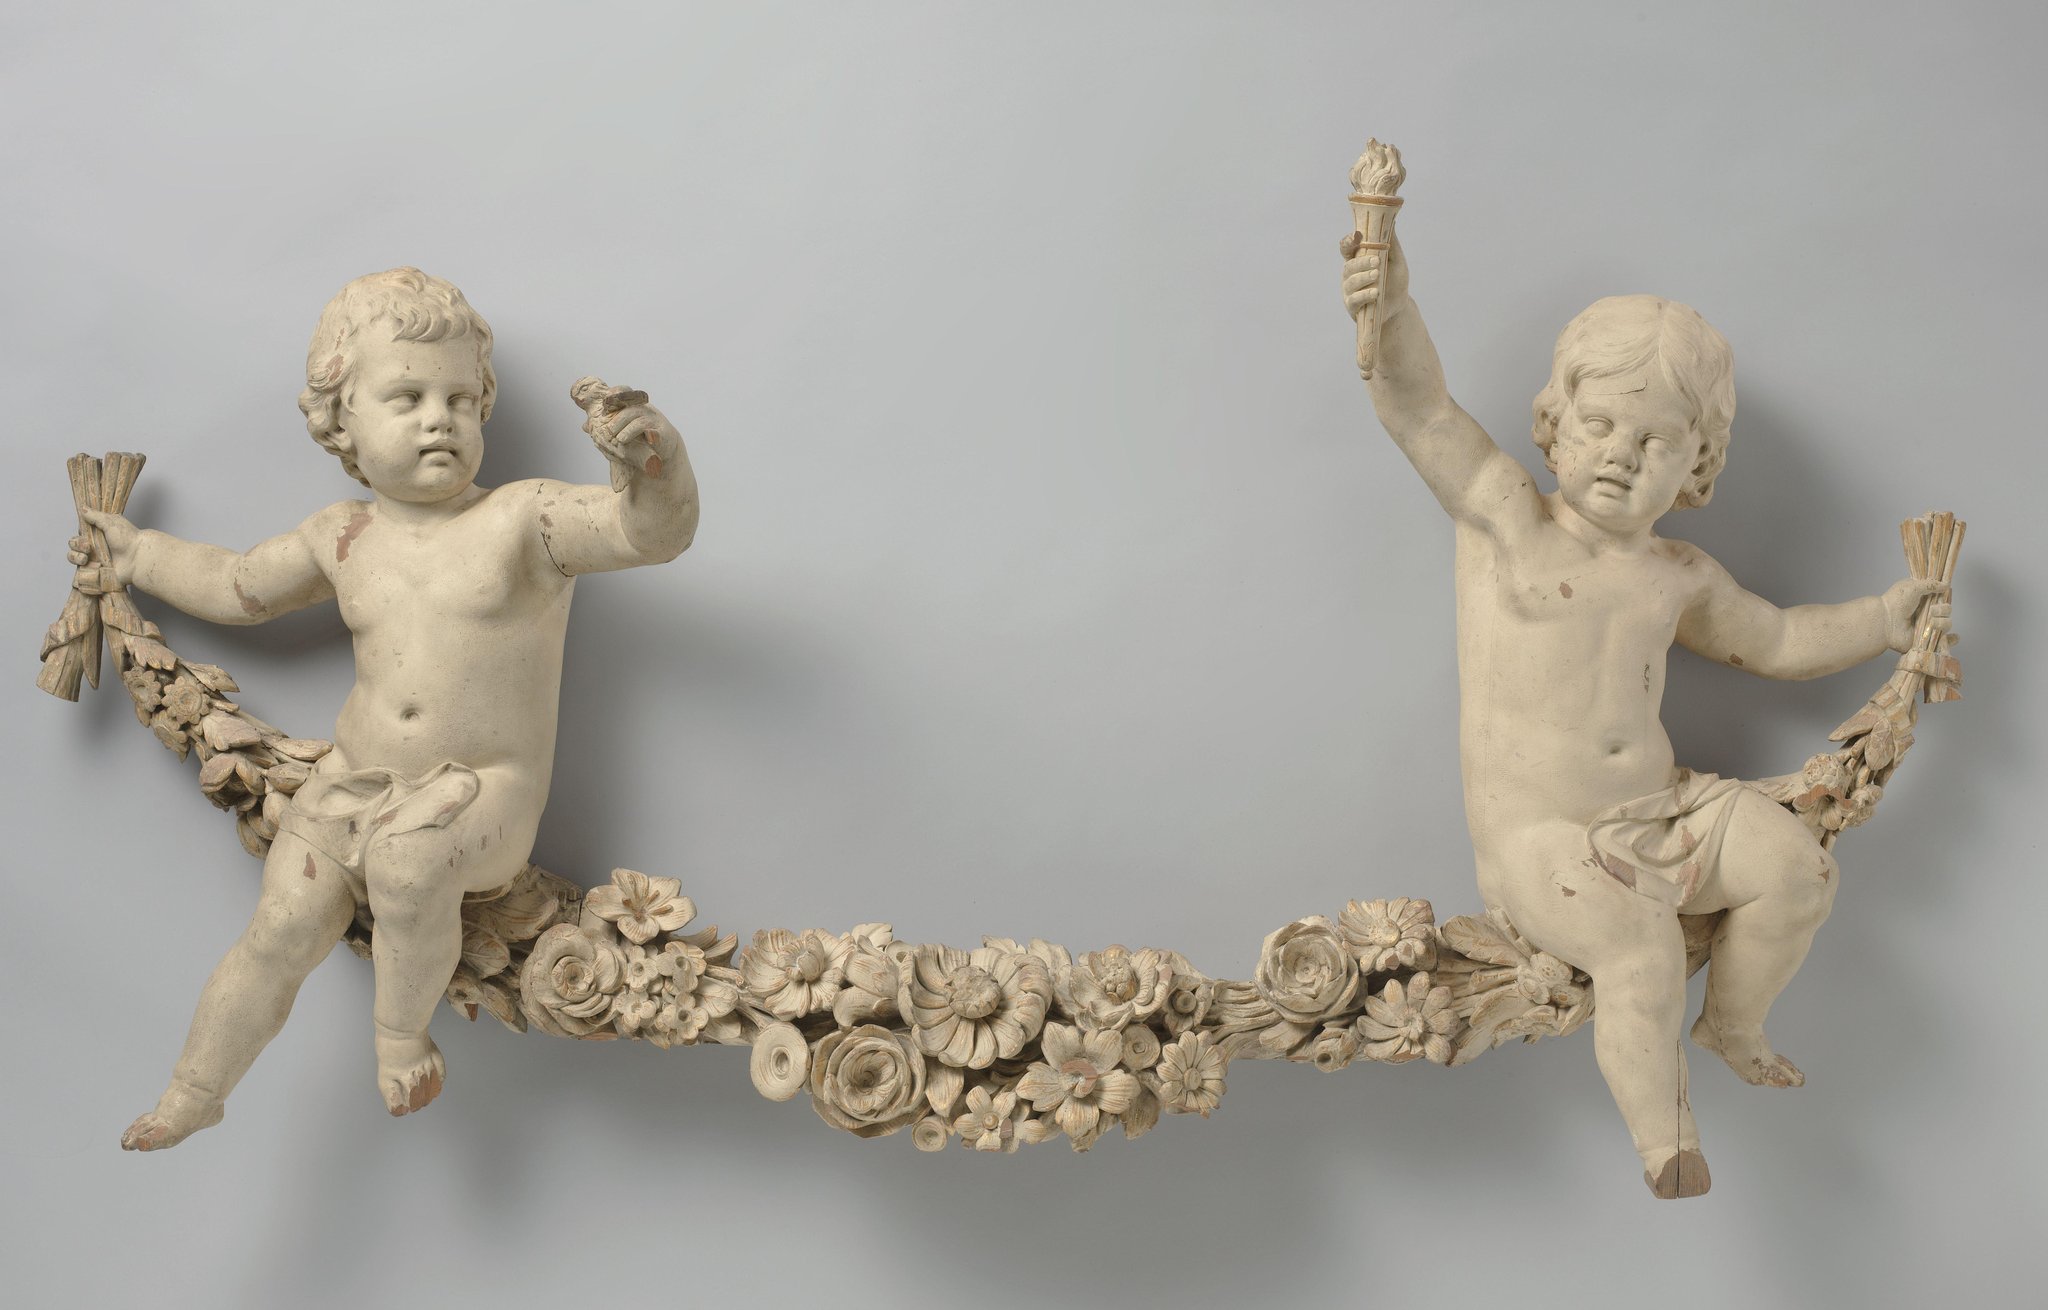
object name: sculpture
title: De vier elementen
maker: michiel emanuel shee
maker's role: sculptor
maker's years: -1740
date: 1730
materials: wood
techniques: cutting, painted